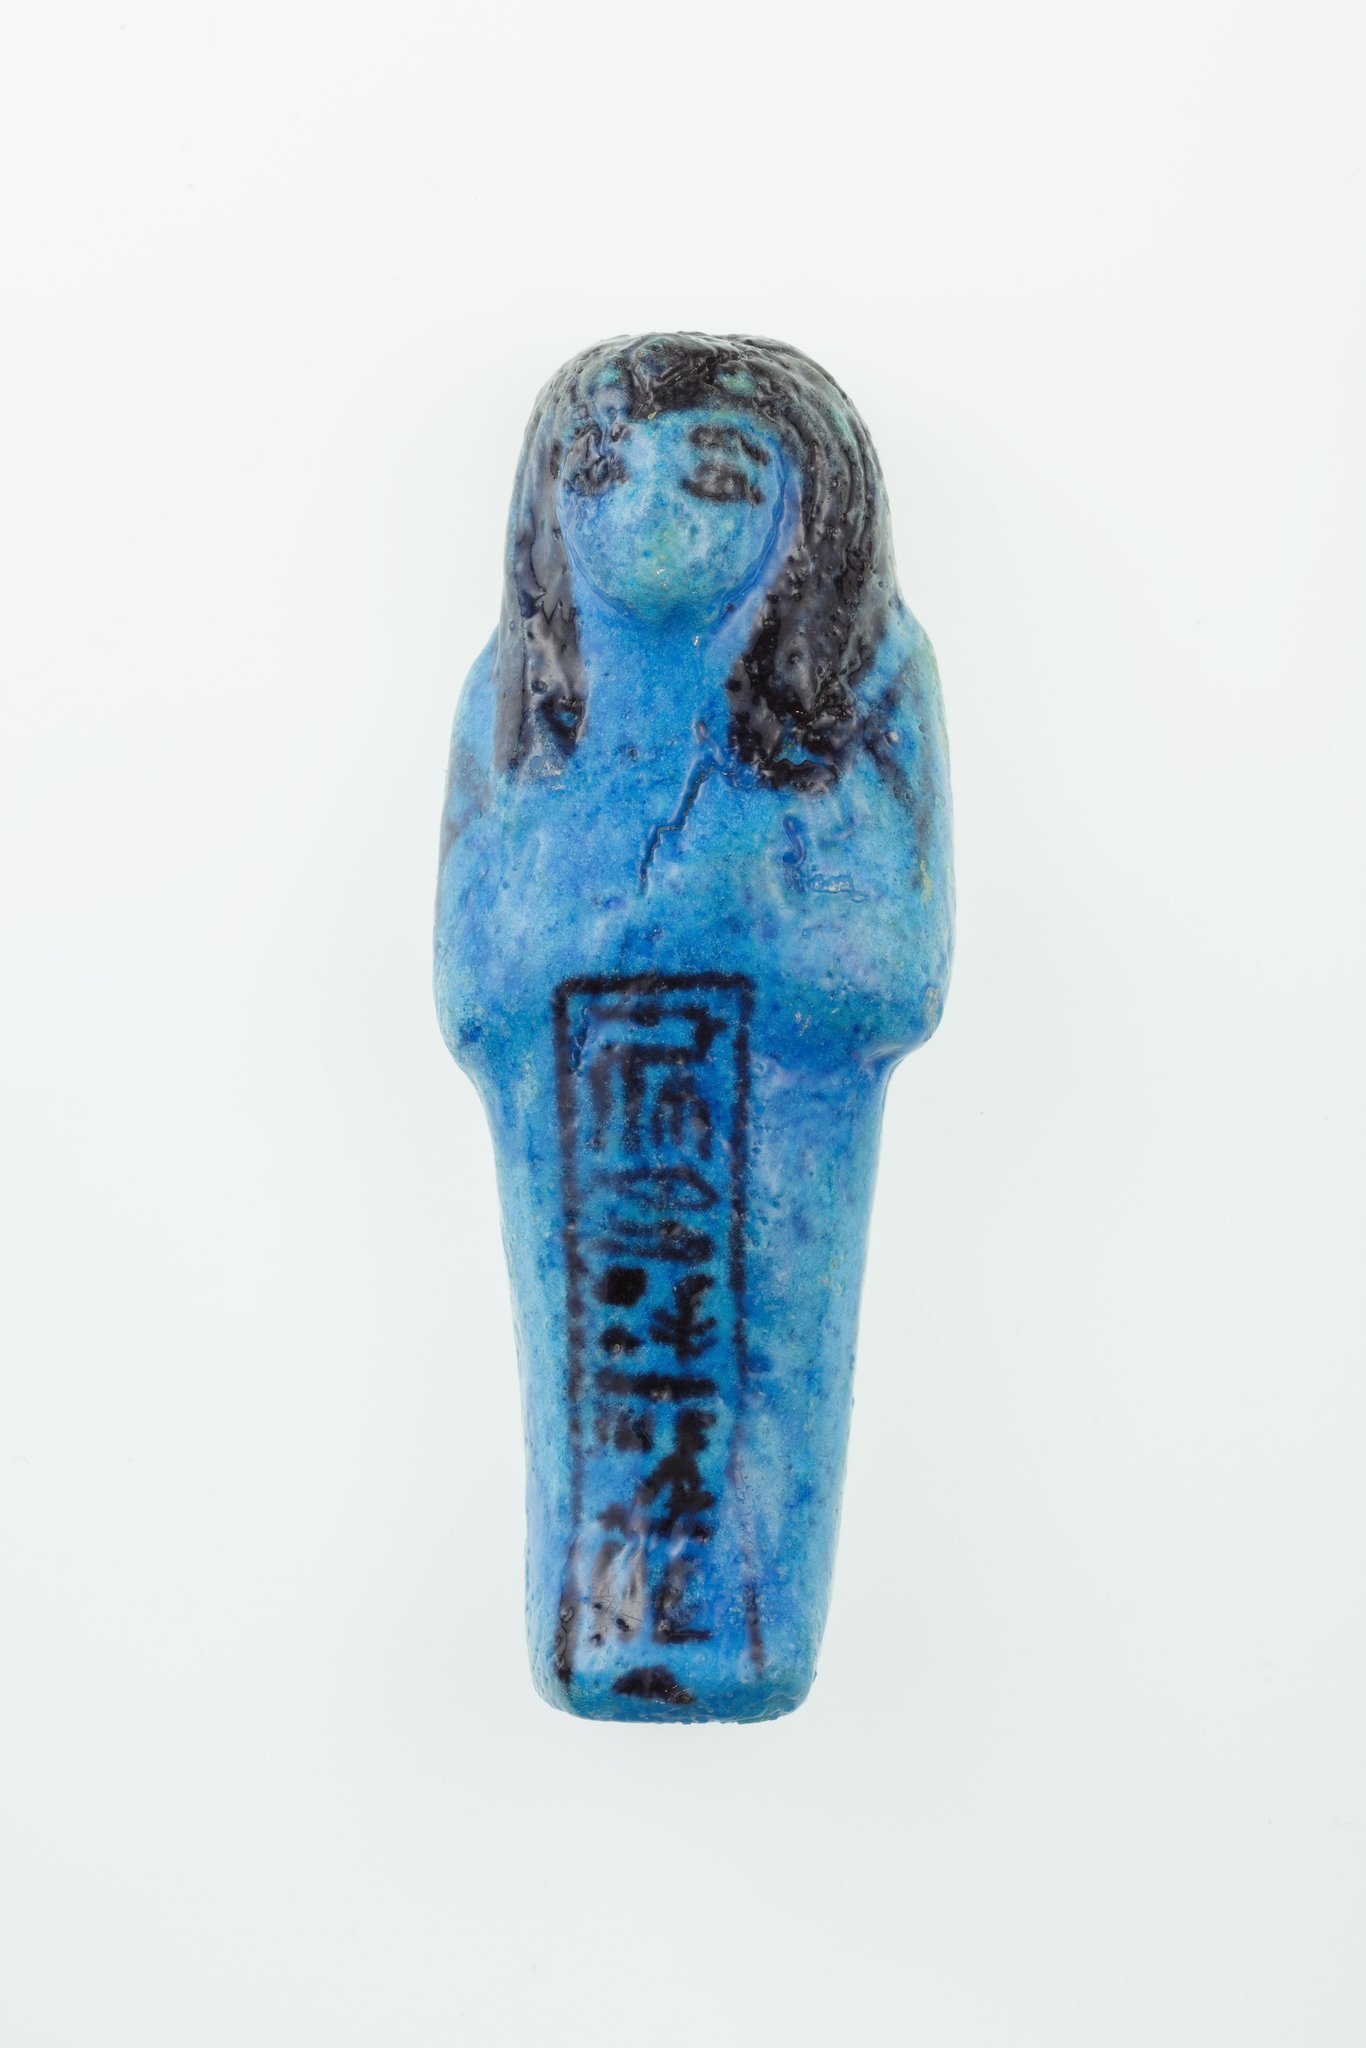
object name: shabti, nauny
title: Worker Shabti of Nauny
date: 1050 BCE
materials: faience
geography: egypt